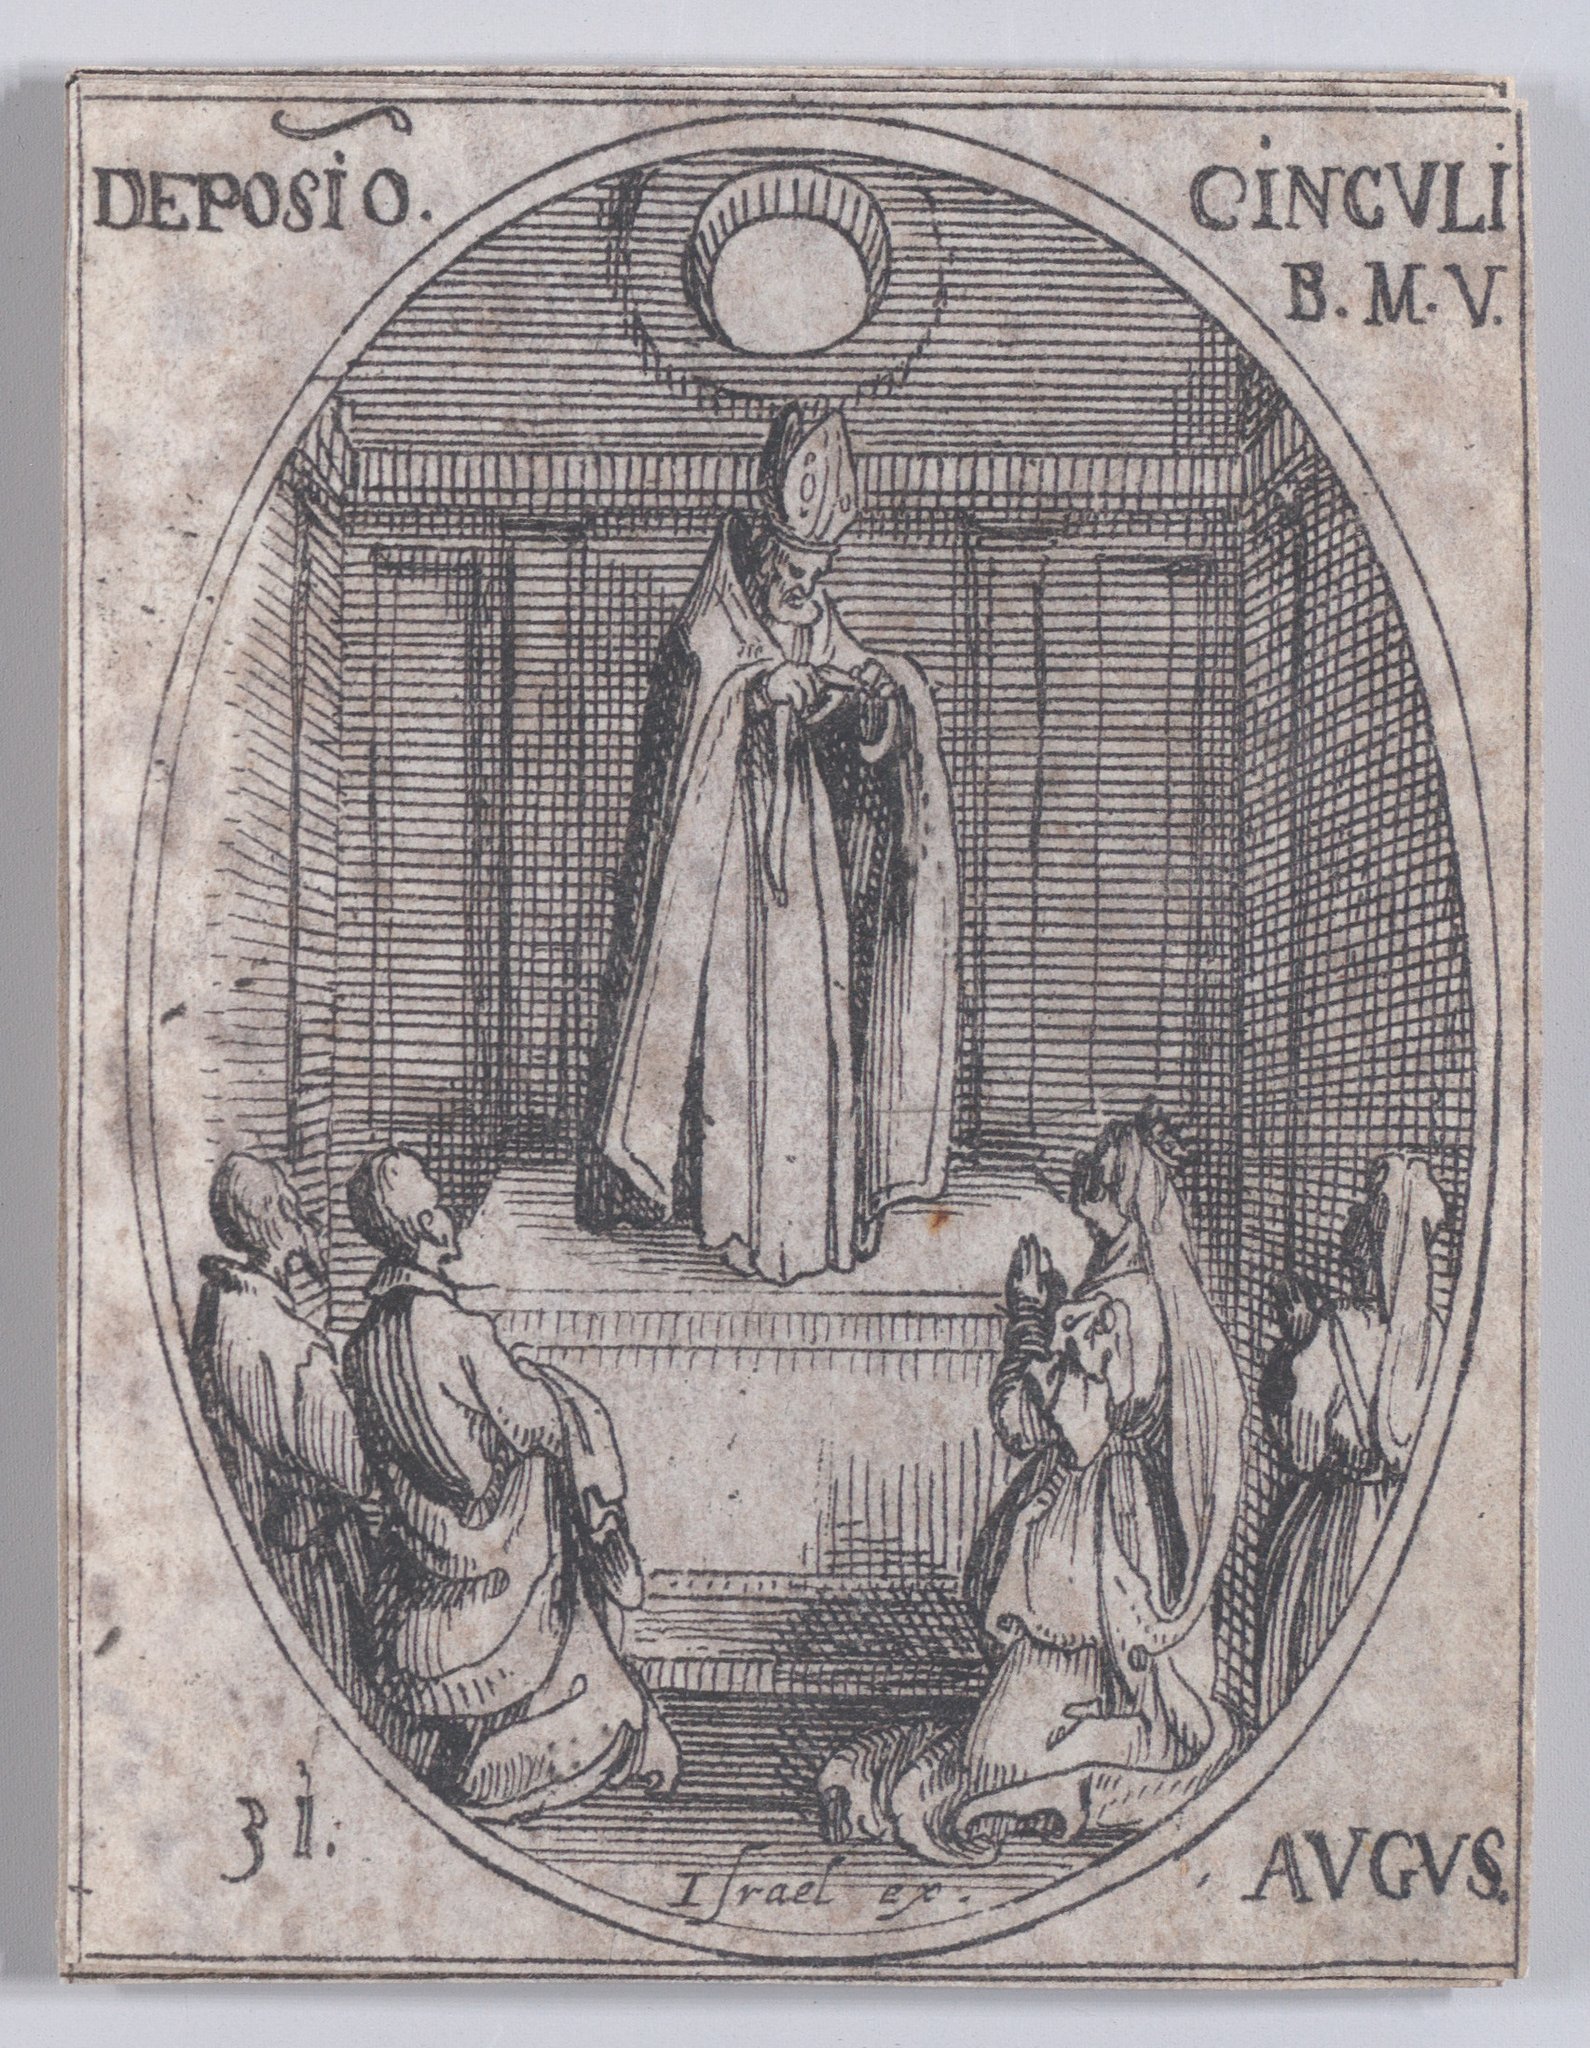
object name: print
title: Fête à la Sainte Vierge (Celebration of the Blessed Virgin), August 31st, from "Les Images De Tous Les Saincts et Saintes de L'Année" (Images of All of the Saints and Religious Events of the Year)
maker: jacques callot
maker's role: artist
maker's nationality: french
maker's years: 1592-1635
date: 1636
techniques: etching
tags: men,virgin mary